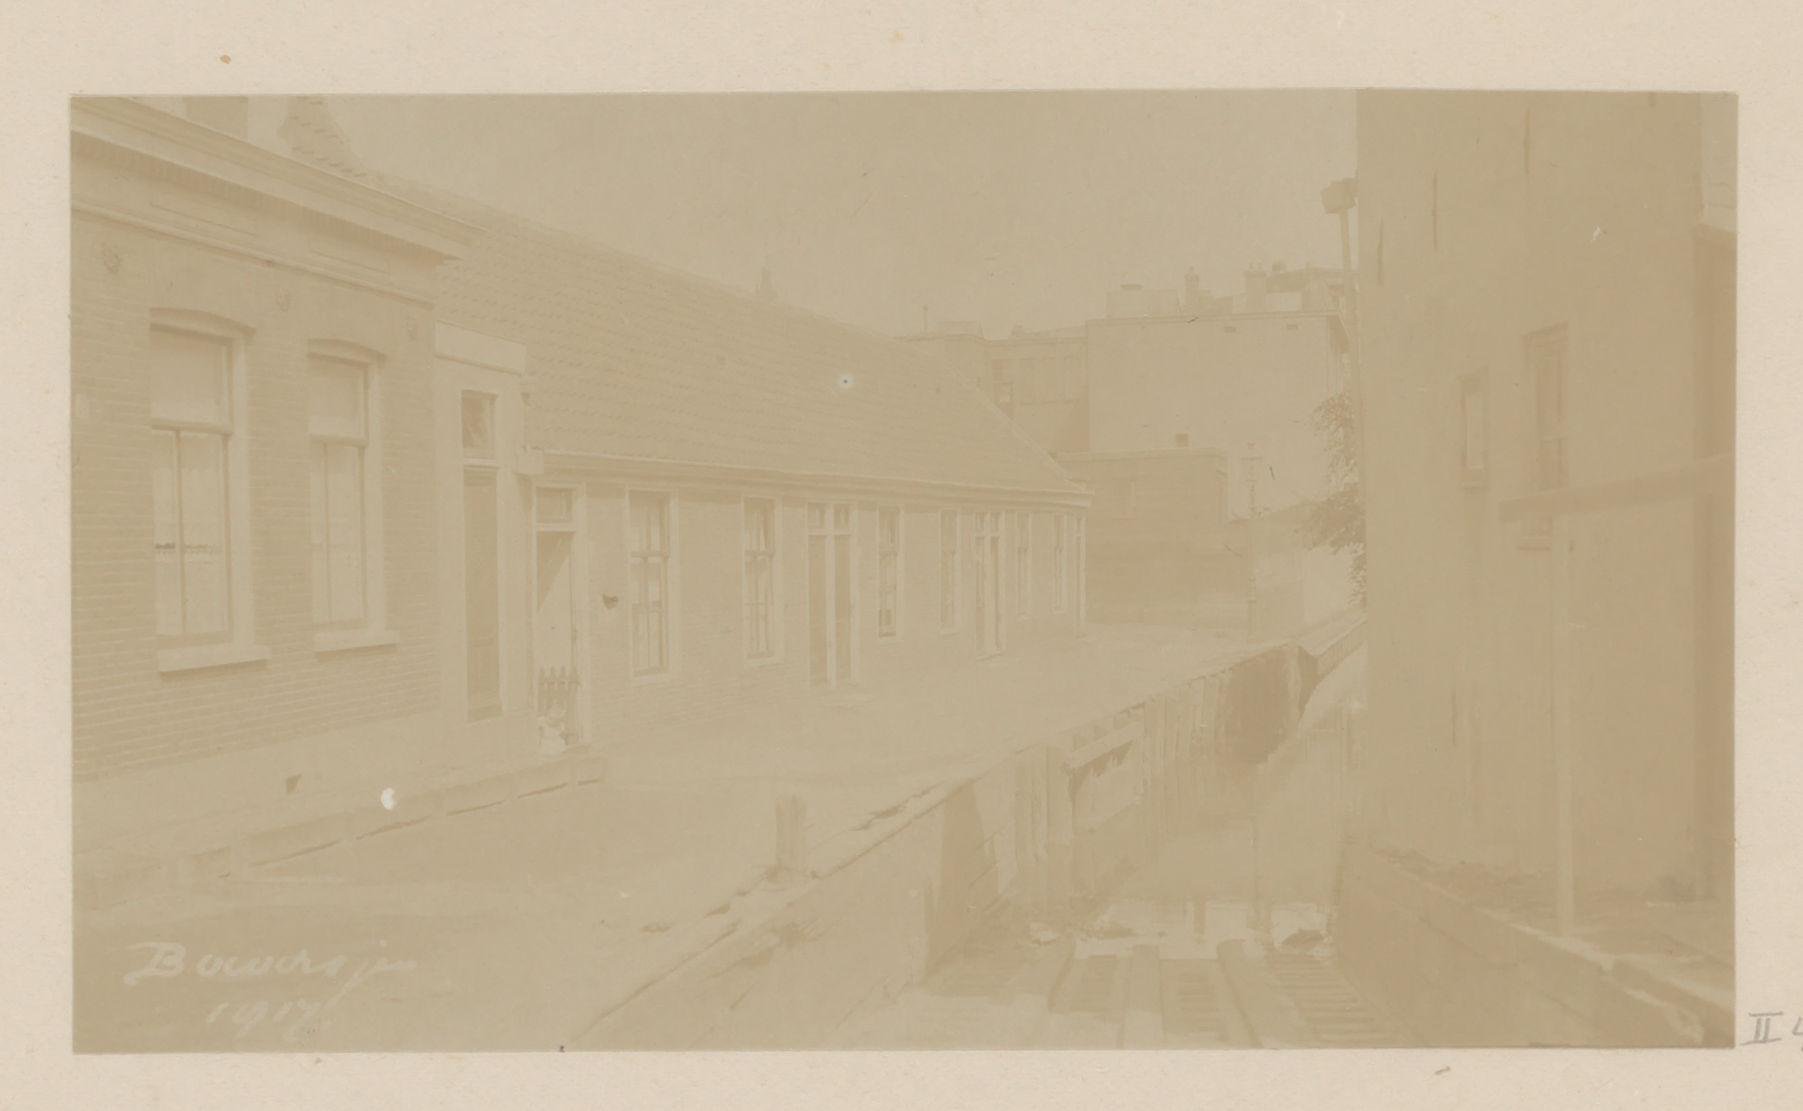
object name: photograph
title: Gezicht op de Baarsjes, hoek Slatuinenpad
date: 1917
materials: cardboard, paper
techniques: albumen print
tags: city-view in general; 'veduta', the usual house or row of houses, street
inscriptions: inscription: ‘Baarsjes / 1917.’, inscription: ‘April 1920 / Geschenk v/d Heer J. van Eck. / Baarsjes hoek Slatuinenpad. / in 1917.’, collector's mark: ‘2-’ Lugt 1641b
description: Onderwerpsrubriek binnen de Atlas Amsterdam: Kostverloren Wetering.